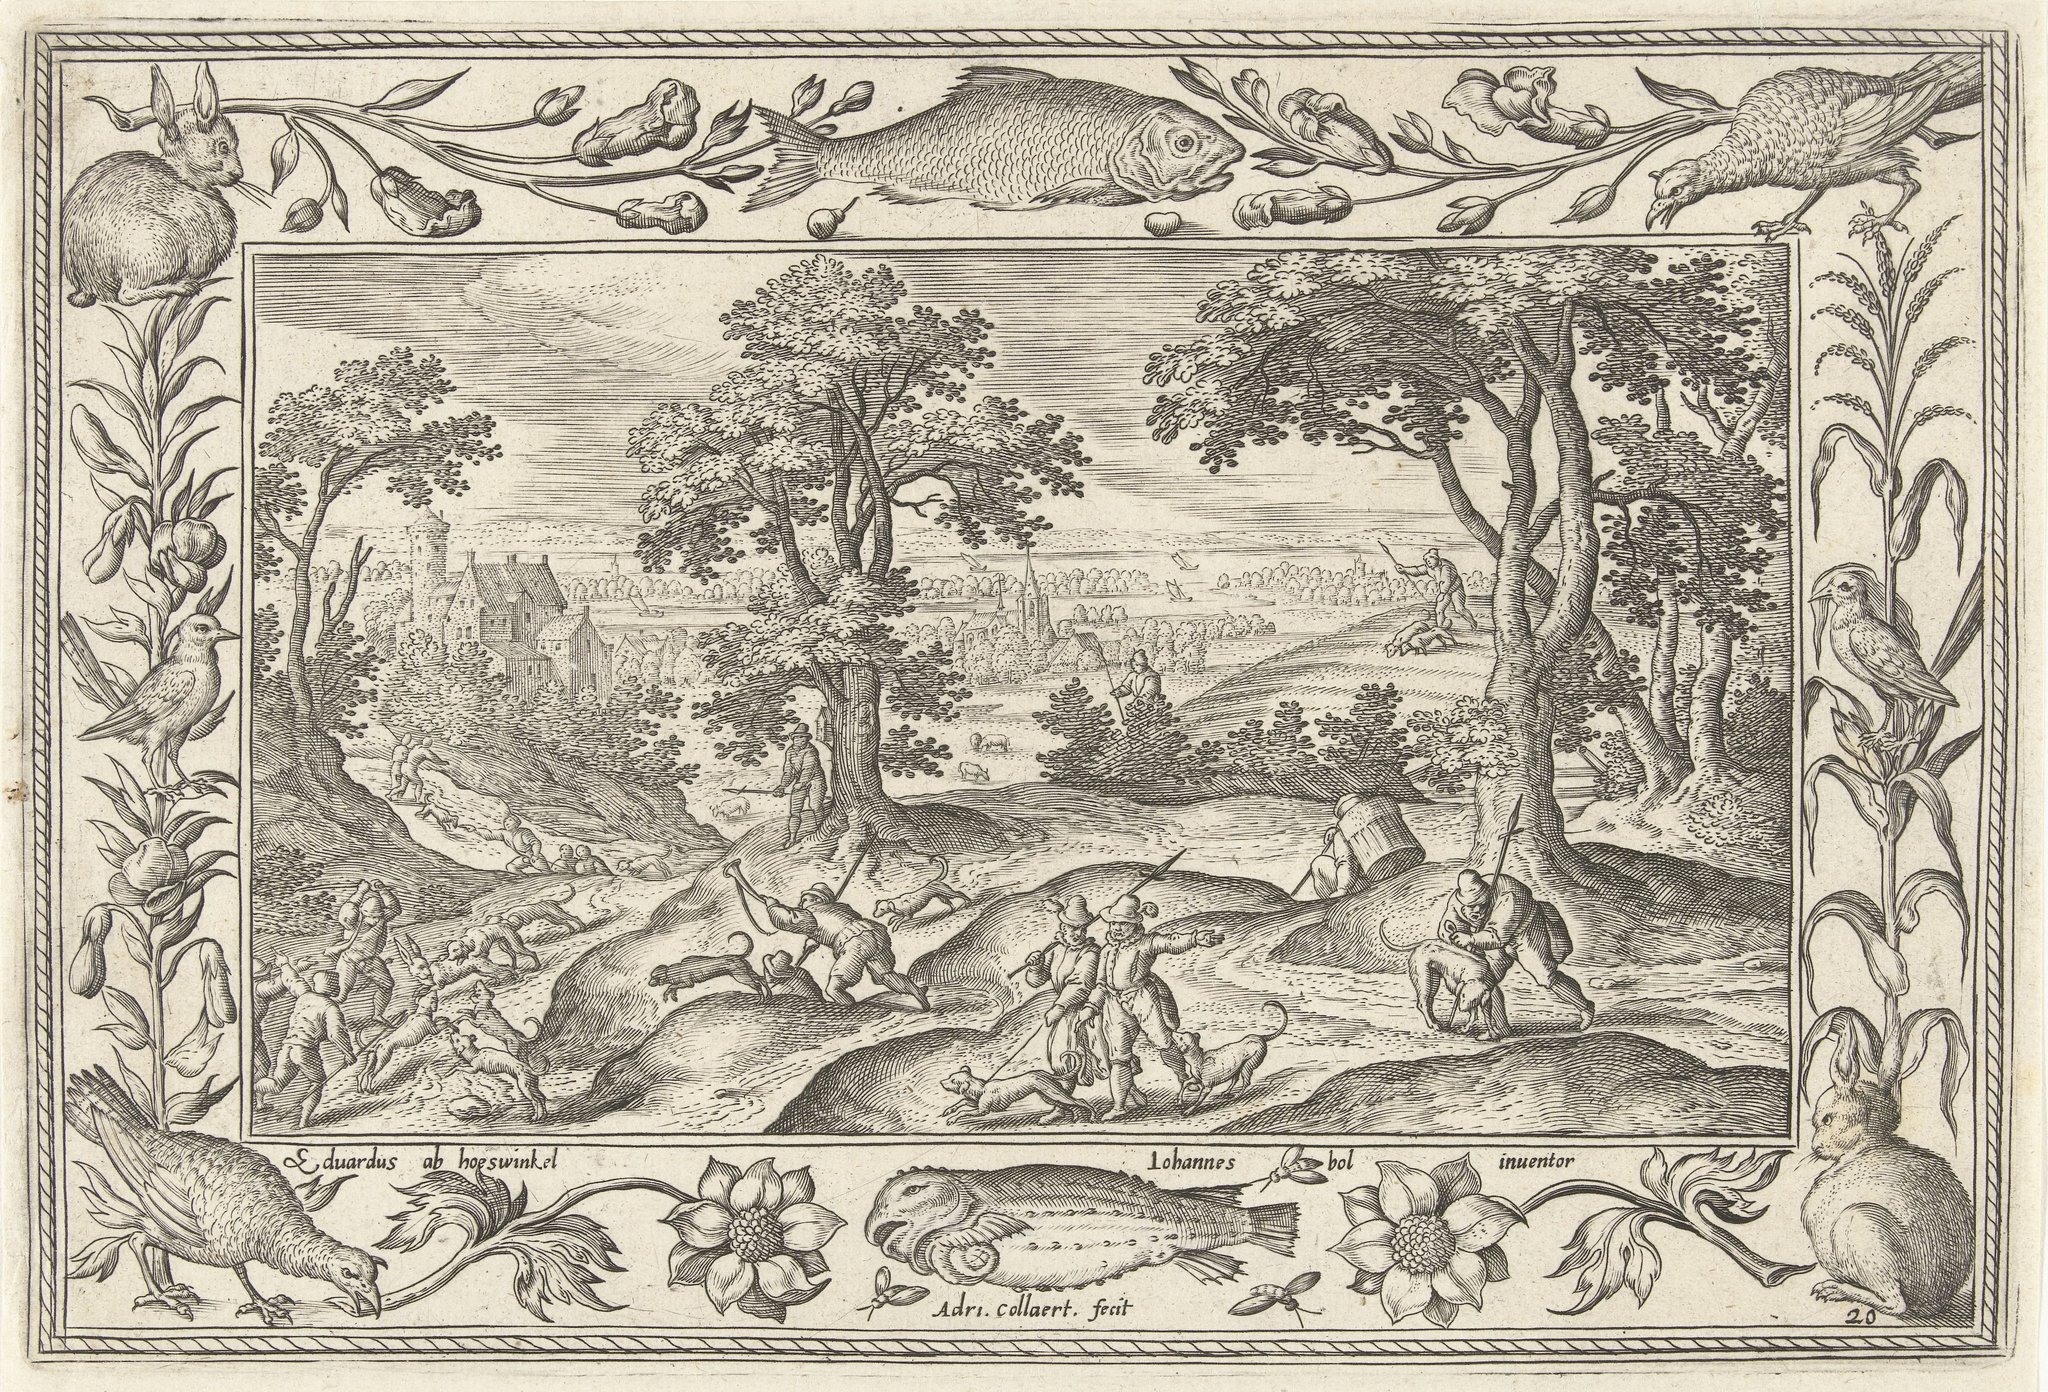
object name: print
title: Hazenjacht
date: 1582-1586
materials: paper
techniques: engraving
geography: antwerp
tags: ornamental birds, forest, wood, fishes (+ ornamental variants of animals), rodents (with name) (+ ornamental variants of animals), hare-hunting, rabbit-hunting (+ hunting with dogs), flowers ~ ornament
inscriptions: collector's mark: Lugt 2228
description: Boslandschap met hazenjacht. Op de voorgrond zoeken jagers met hun honden naar wild. Links wordt een haas opgejaagd door verschillende honden. De prent heeft een ornamentele lijst met bloemen, vissen en dieren. Hij maakt deel uit van een vierentwintigdelige serie van landschappen met Bijbelse, mythologische scènes en jachttaferelen.